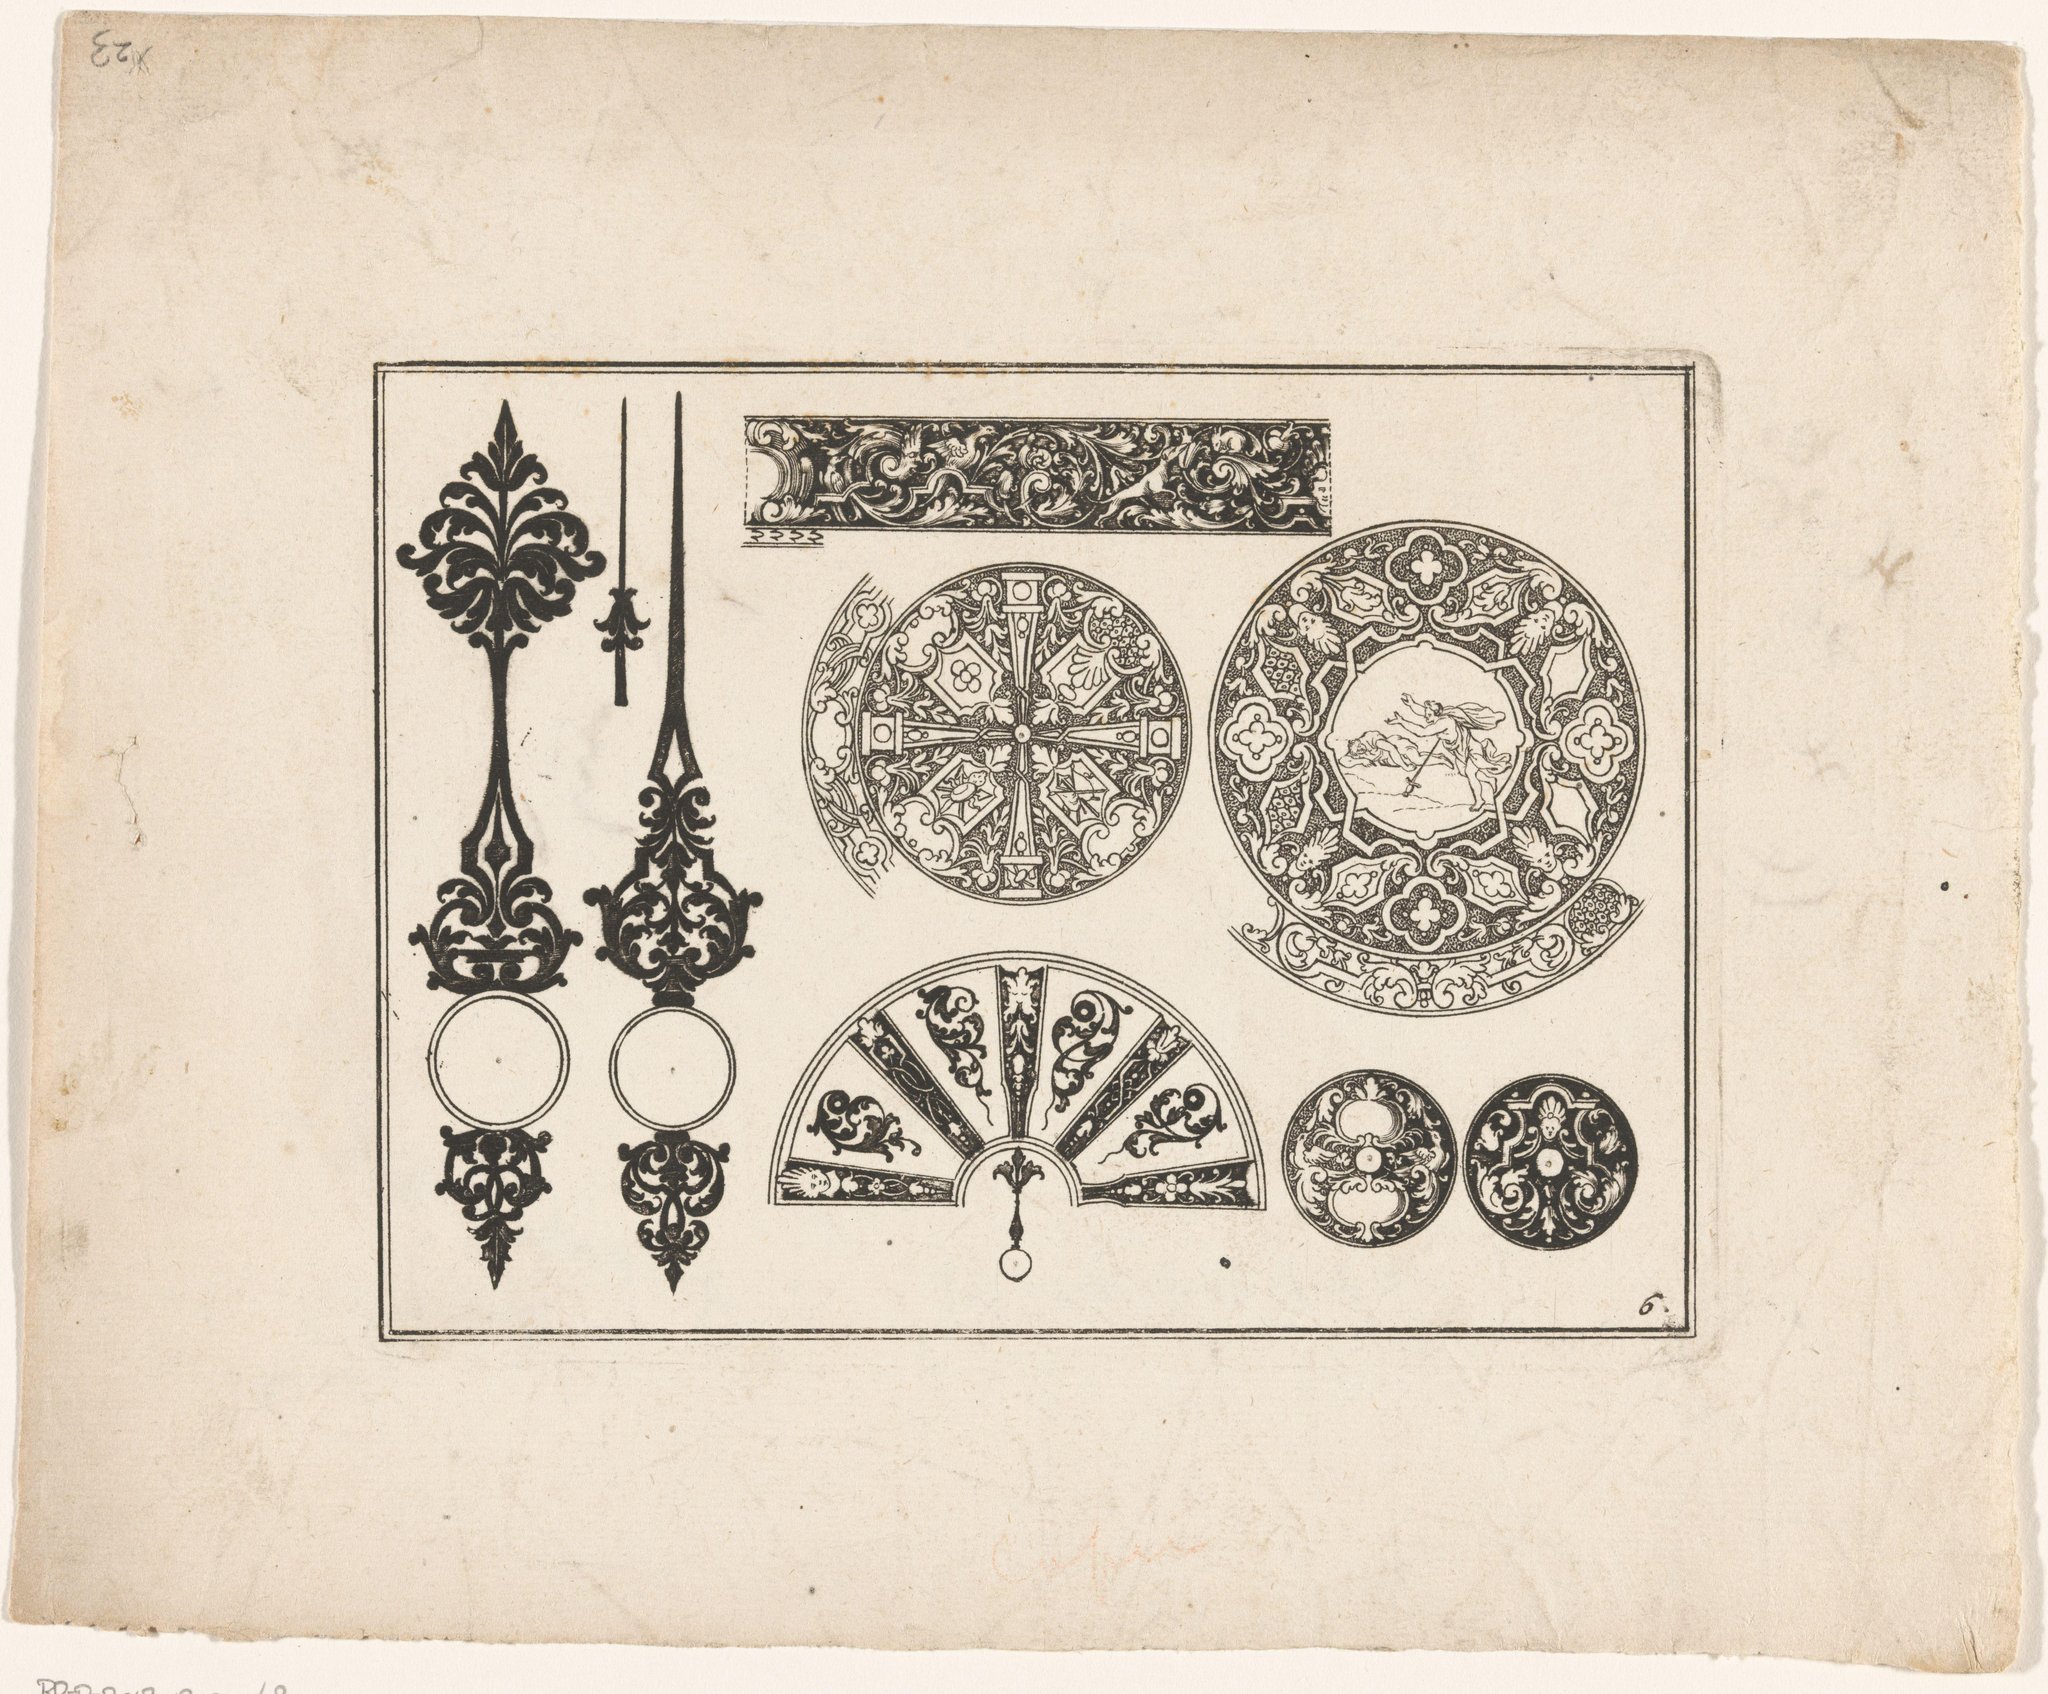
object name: print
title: Verscheidene ontwerpen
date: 1703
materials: paper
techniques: etching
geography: germany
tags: ornaments ~ art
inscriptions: number: ‘6’, collector's mark: Lugt 2228, collector's mark: Lugt 2760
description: Gespiegelde Duitse kopie van Pierre Bourdon's Livre Premier: Essais de gravure (1703). Blad uit serie van zeven van ontwerpen voor horlogemakers, goudsmeden, beeldhouwers en graveurs. Verscheidene ontwerpen, één medaillon bevat een scène van Pyramus en Thisbe.